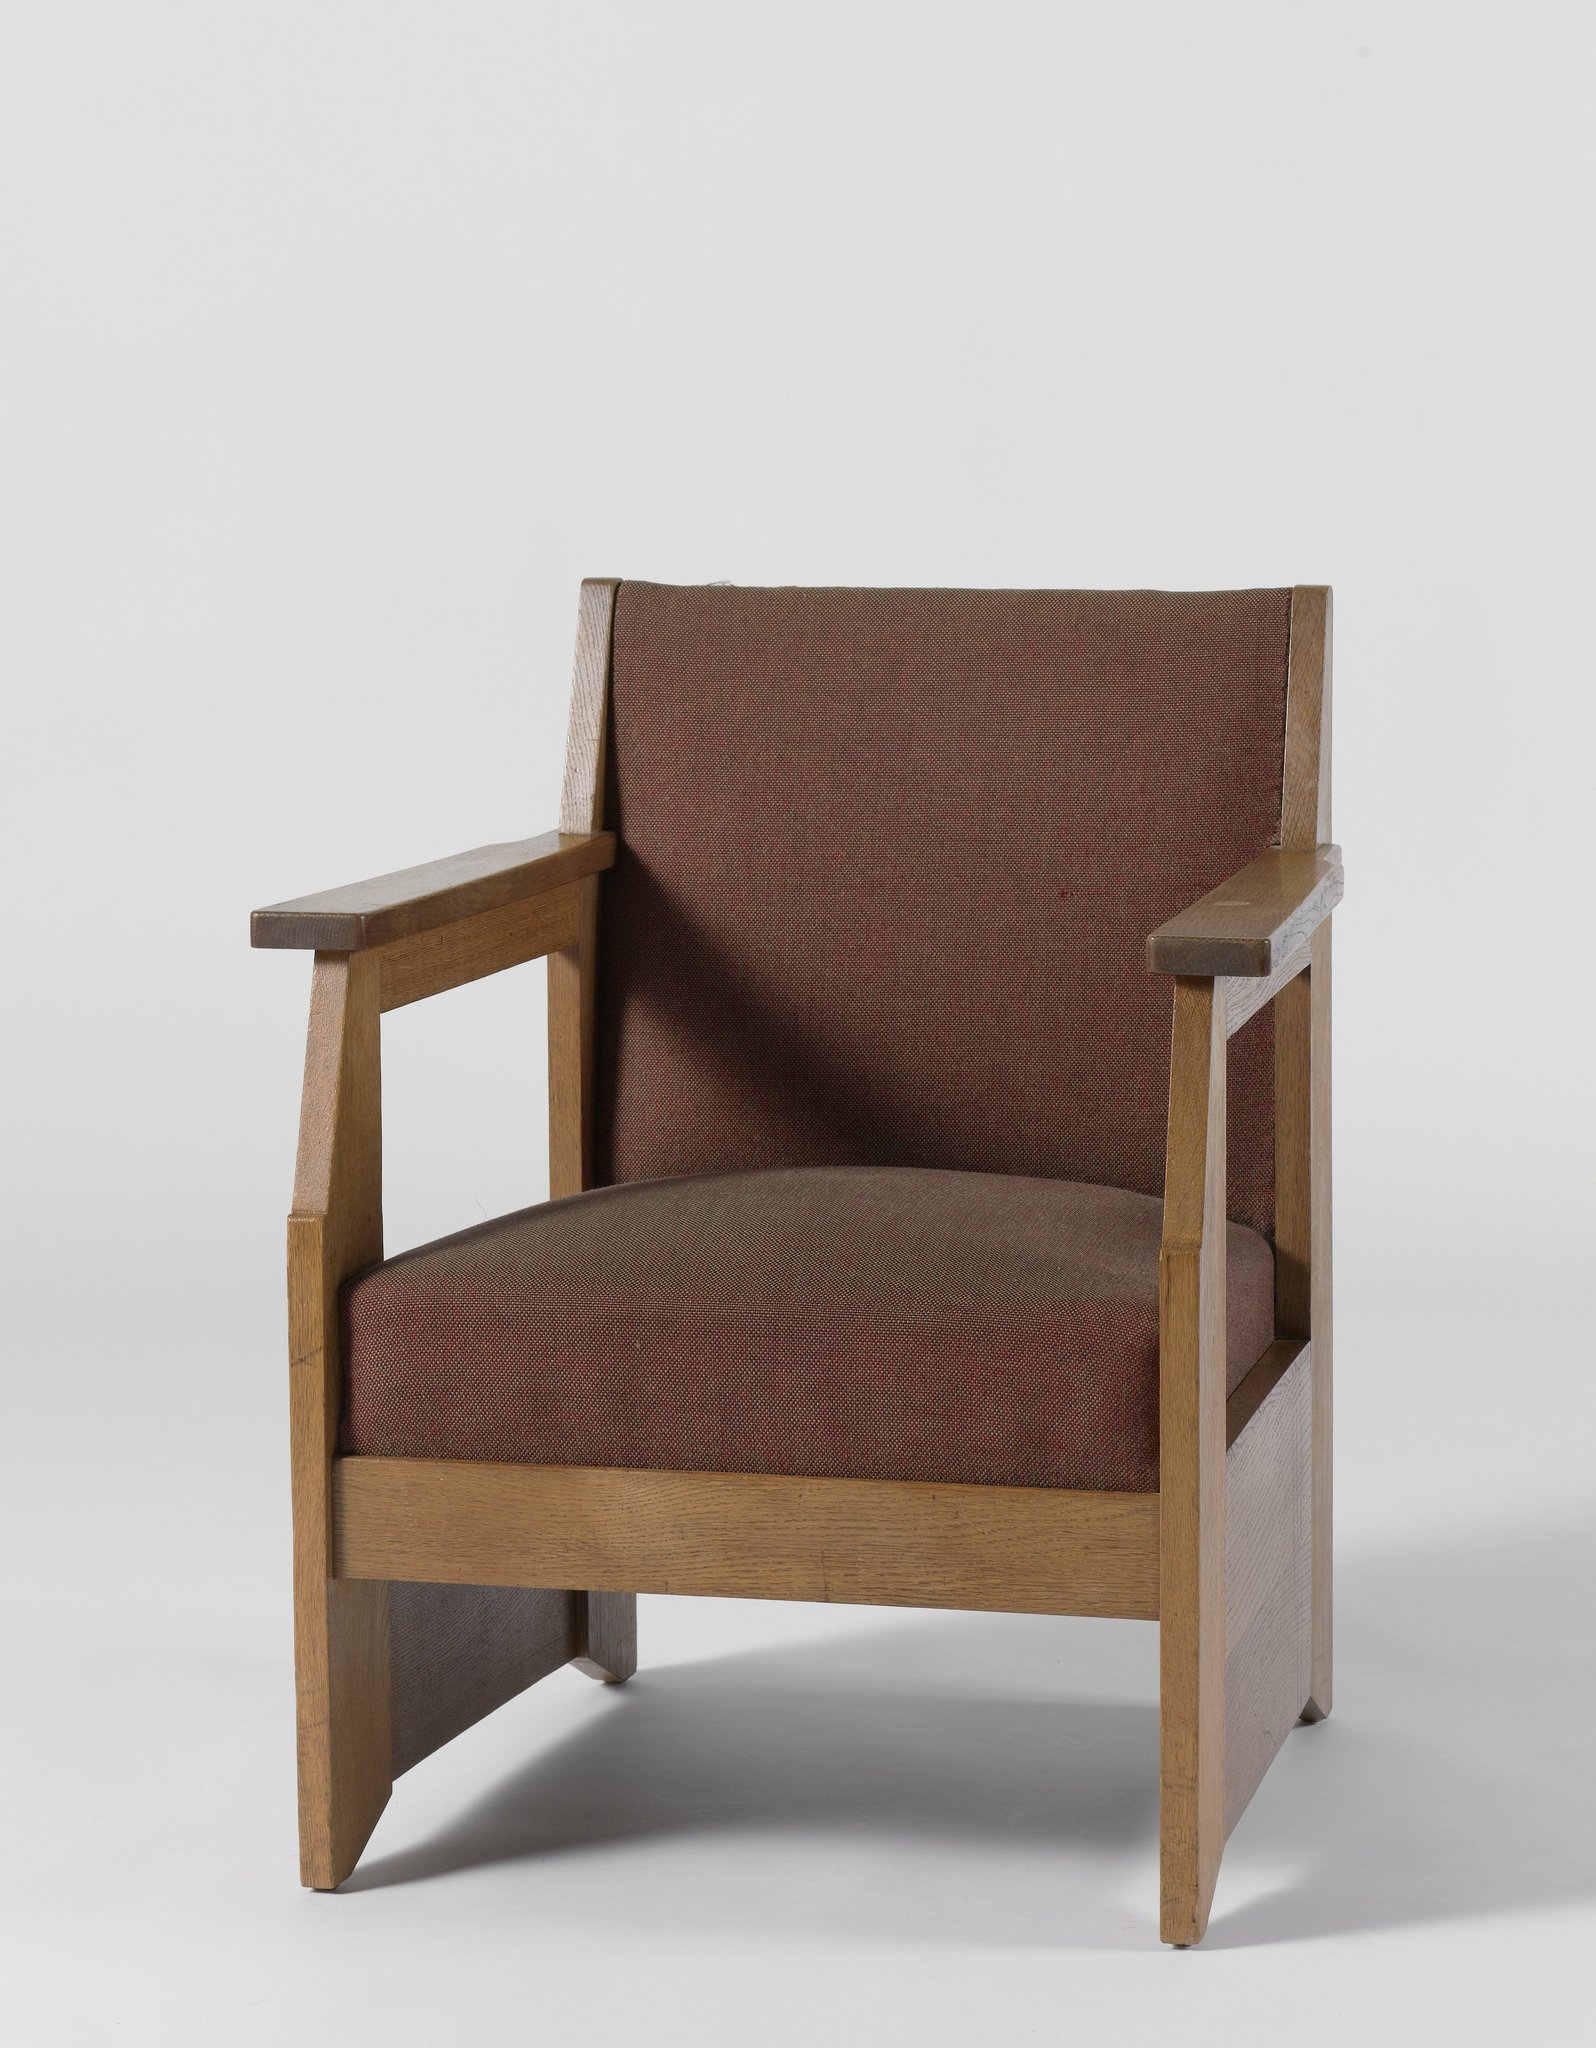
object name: furniture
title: Armstoel met brede zijwanden en bekleed met roodkleurige wol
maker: hendrik wouda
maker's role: furniture worker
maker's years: 1885-1946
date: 1924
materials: wood, wool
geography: the hague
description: Armstoel van eikenhout rustend op vier brede platte poten met afschuinde boven- en onderzijden. De voor- en achterpoten zijn met elkaar verbonden door middel van brede zijwanden. De voorpoten lopen door in de armstutten en de achterpoten lopen door in de rugstijlen. De armstutten en de rugstijlen zijn met elkaar verbonden door middel van een regel waar de armleggers, die in de rugstijlen zijn ingelaten, op rusten. Zowel de zitting als de leuning zijn bekleed met roodkleurige wol.